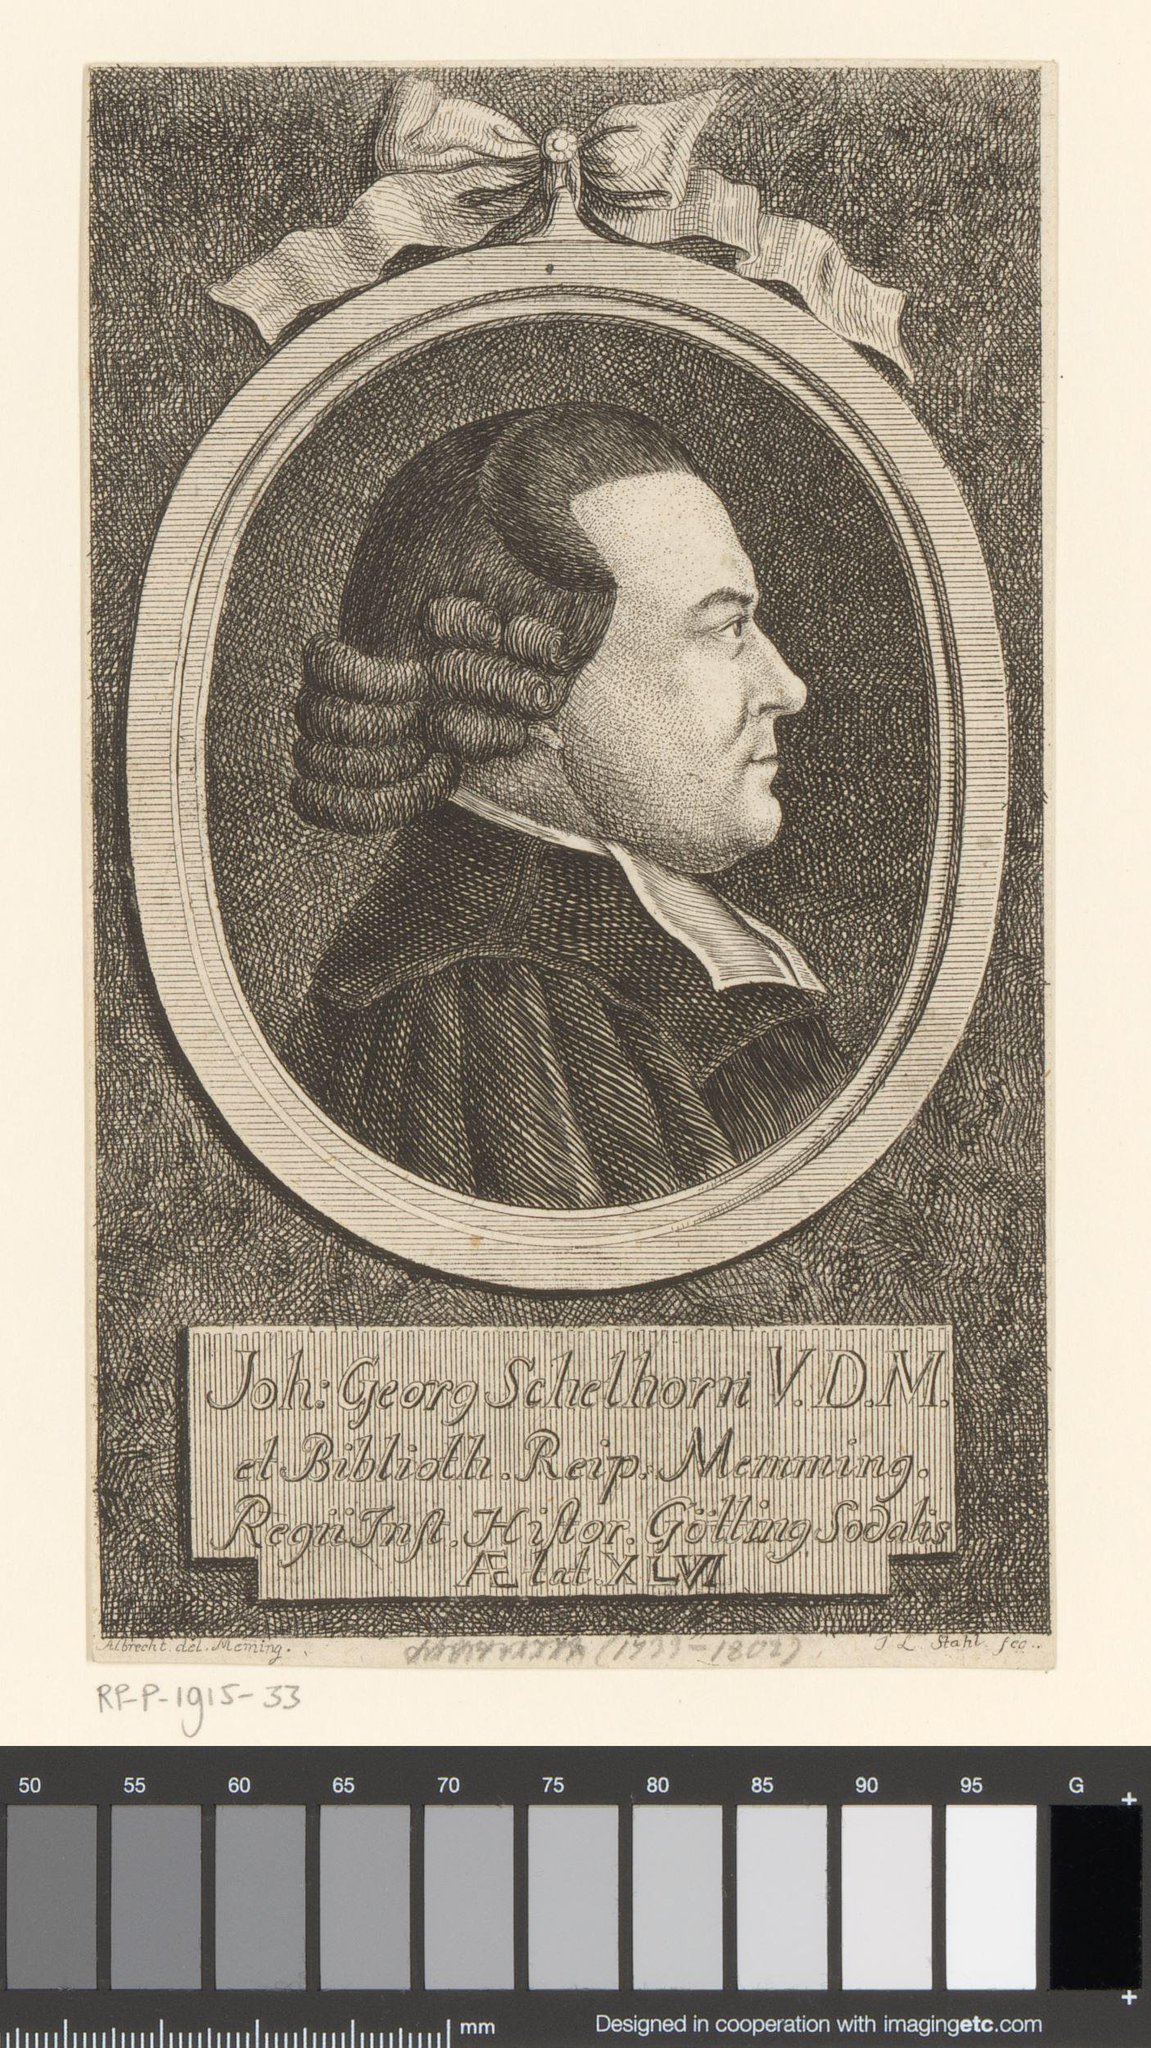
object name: print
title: Portret van Johann Georg II Schelhorn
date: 1779-1853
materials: paper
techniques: etching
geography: memmingen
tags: historical persons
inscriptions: collector's mark: Lugt 2228